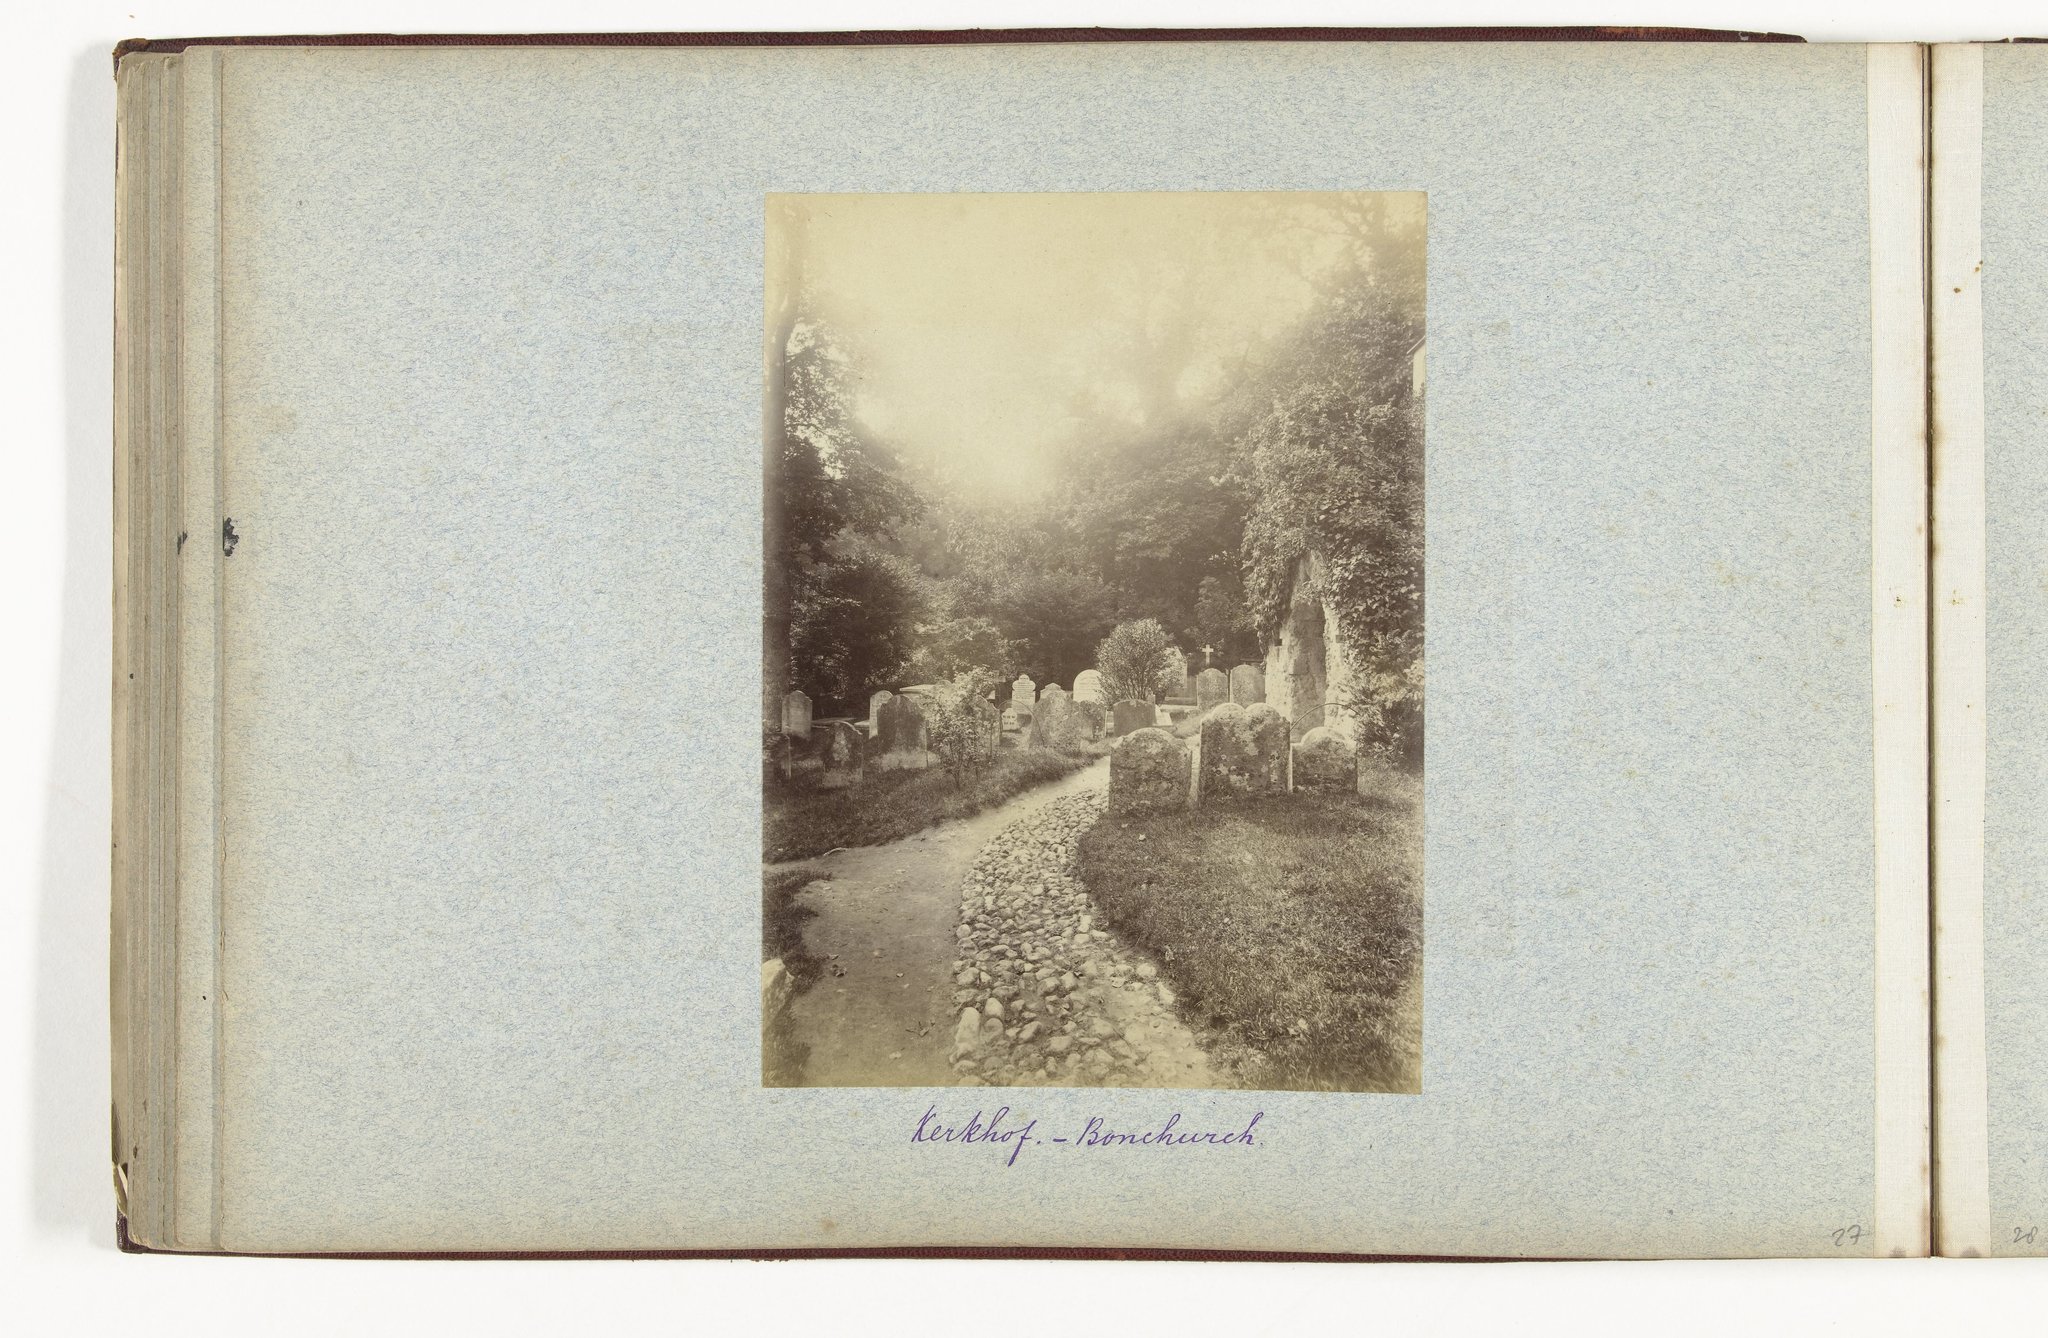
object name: photograph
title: Kerkhof.- Bonchurch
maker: henry pauw van wieldrecht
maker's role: fotograaf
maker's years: 1863-1912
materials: cardboard, paper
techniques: albumen print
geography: bonchurch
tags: churchyard (around church)